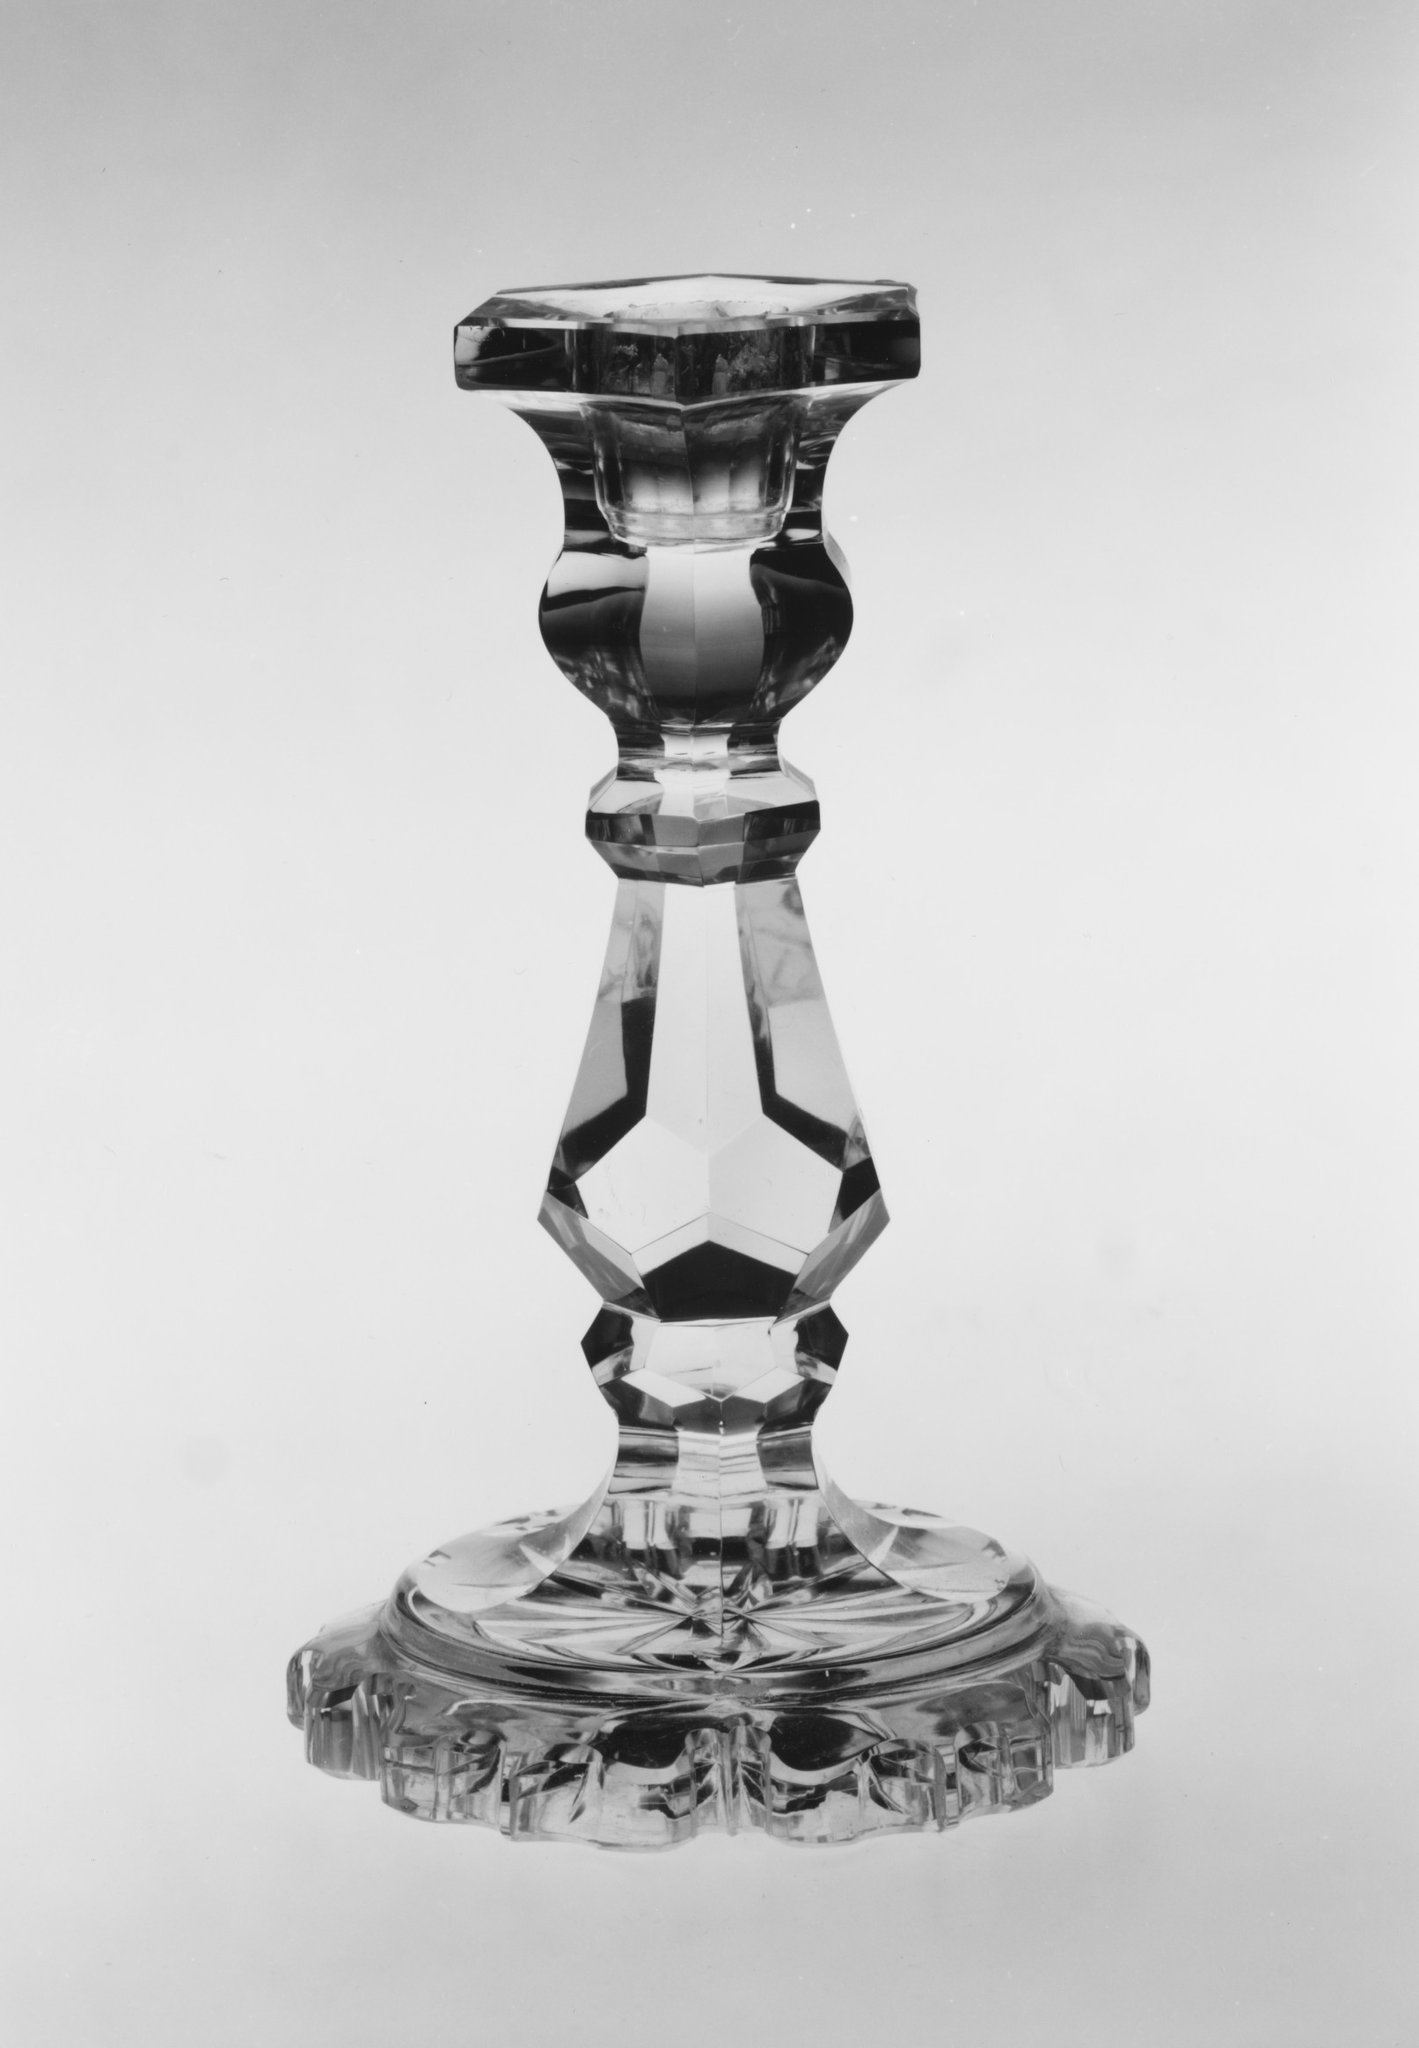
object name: candlestick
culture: american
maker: christian dorflinger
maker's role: maker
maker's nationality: french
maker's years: 1828-1915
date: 1852-1860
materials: glass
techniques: glassblowing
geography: united states